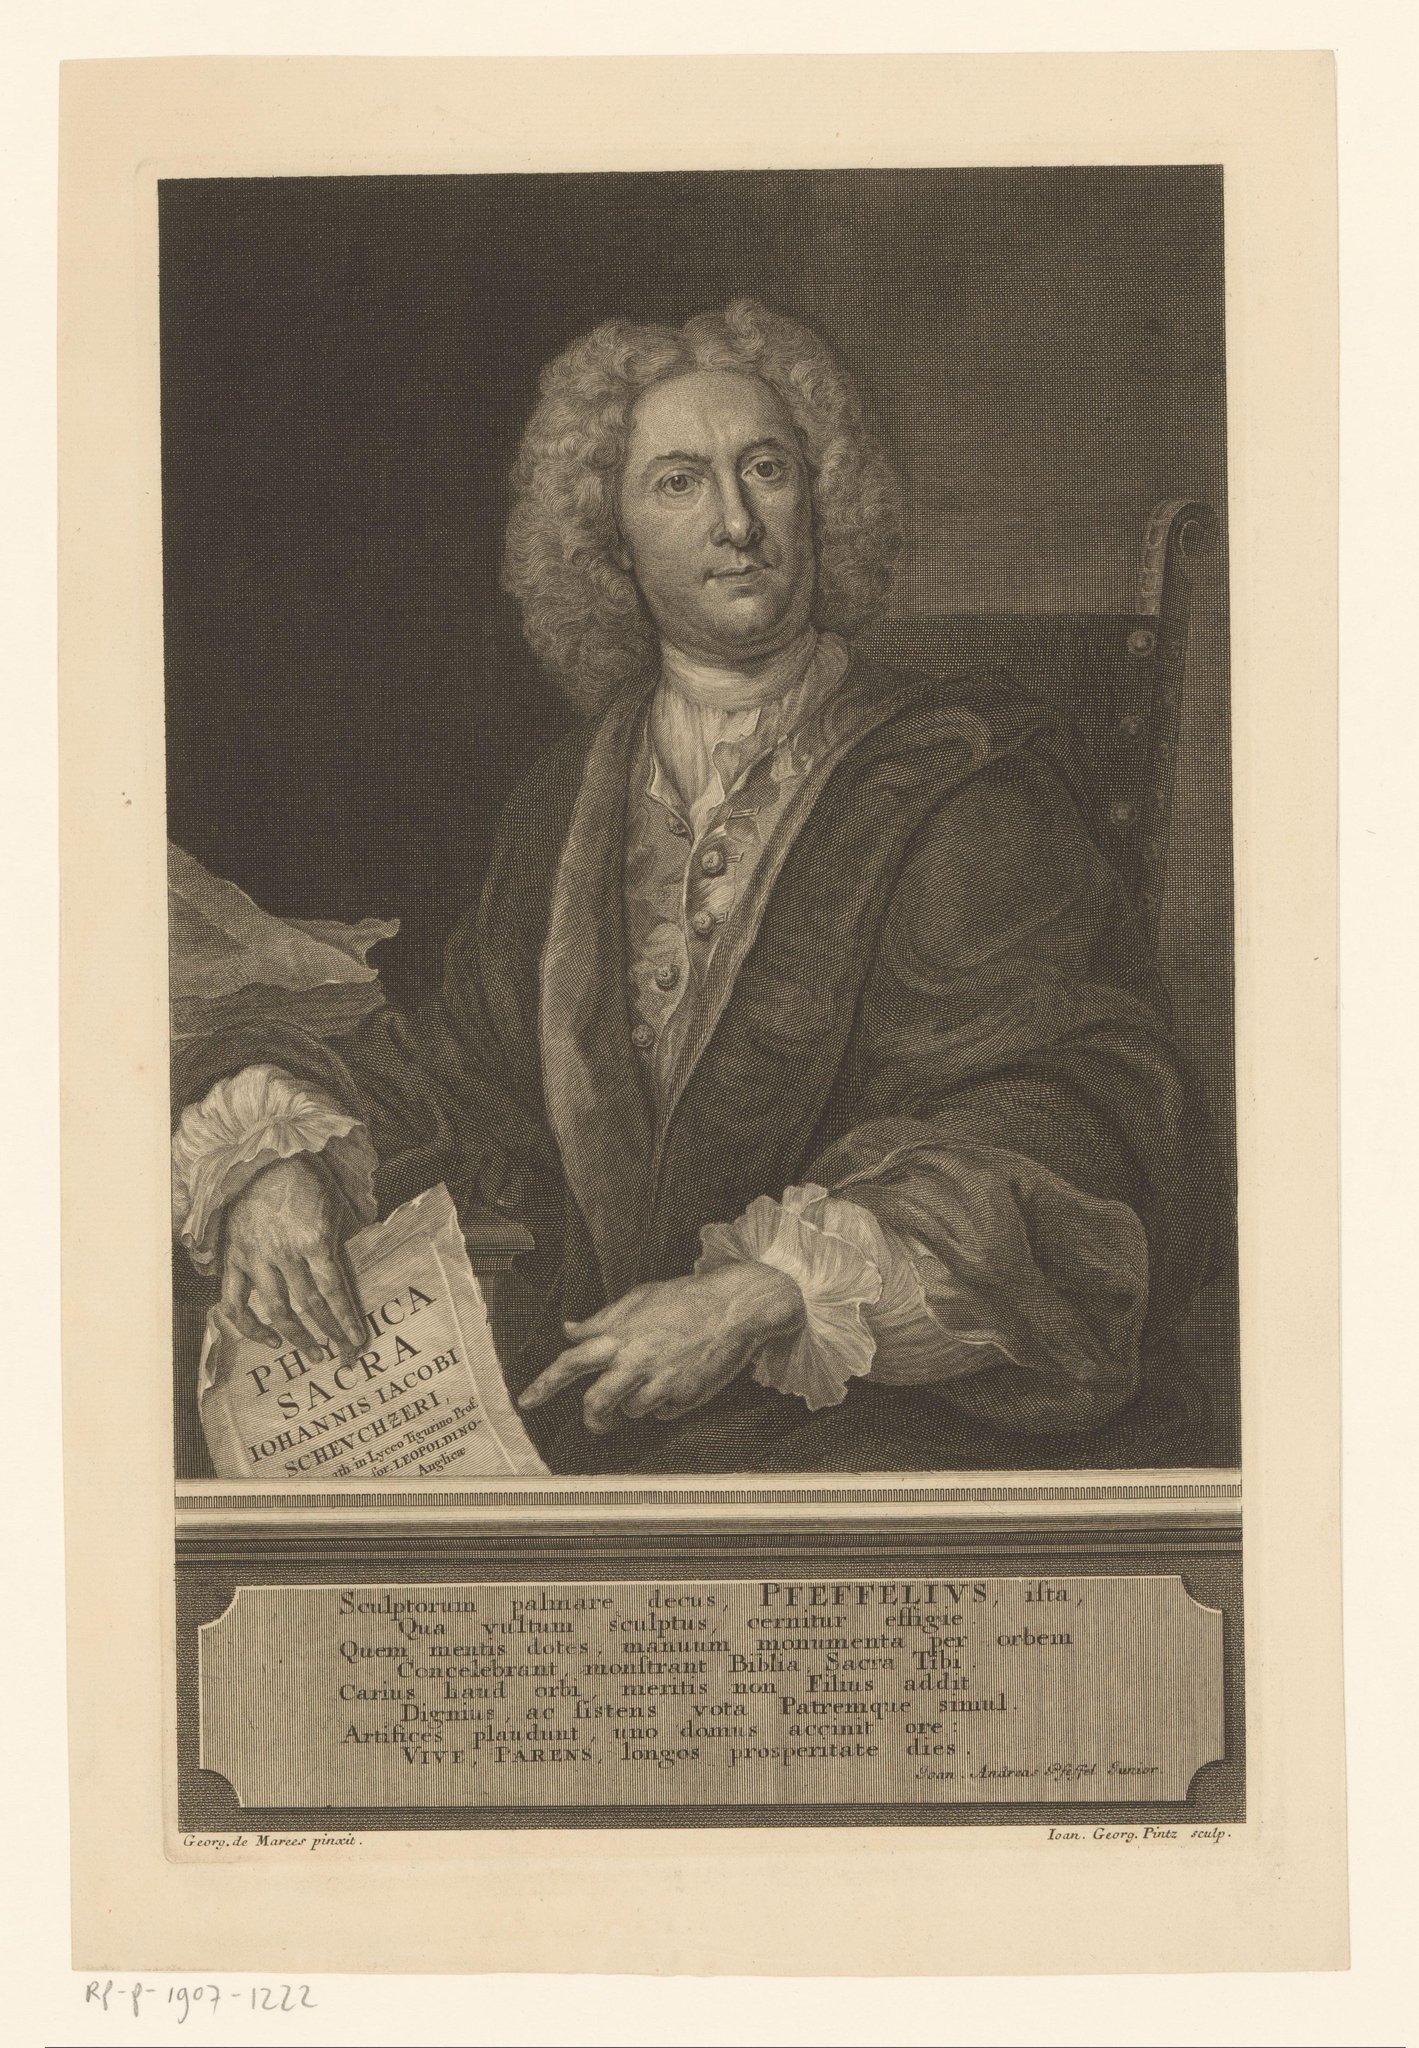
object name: print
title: Portret van Johann Andreas Pfeffel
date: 1707-1767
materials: paper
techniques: engraving, etching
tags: print maker, johann andreas pfeffel (der ältere), historical persons, pamphlet ~ printed matter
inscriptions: collector's mark: Lugt 2228